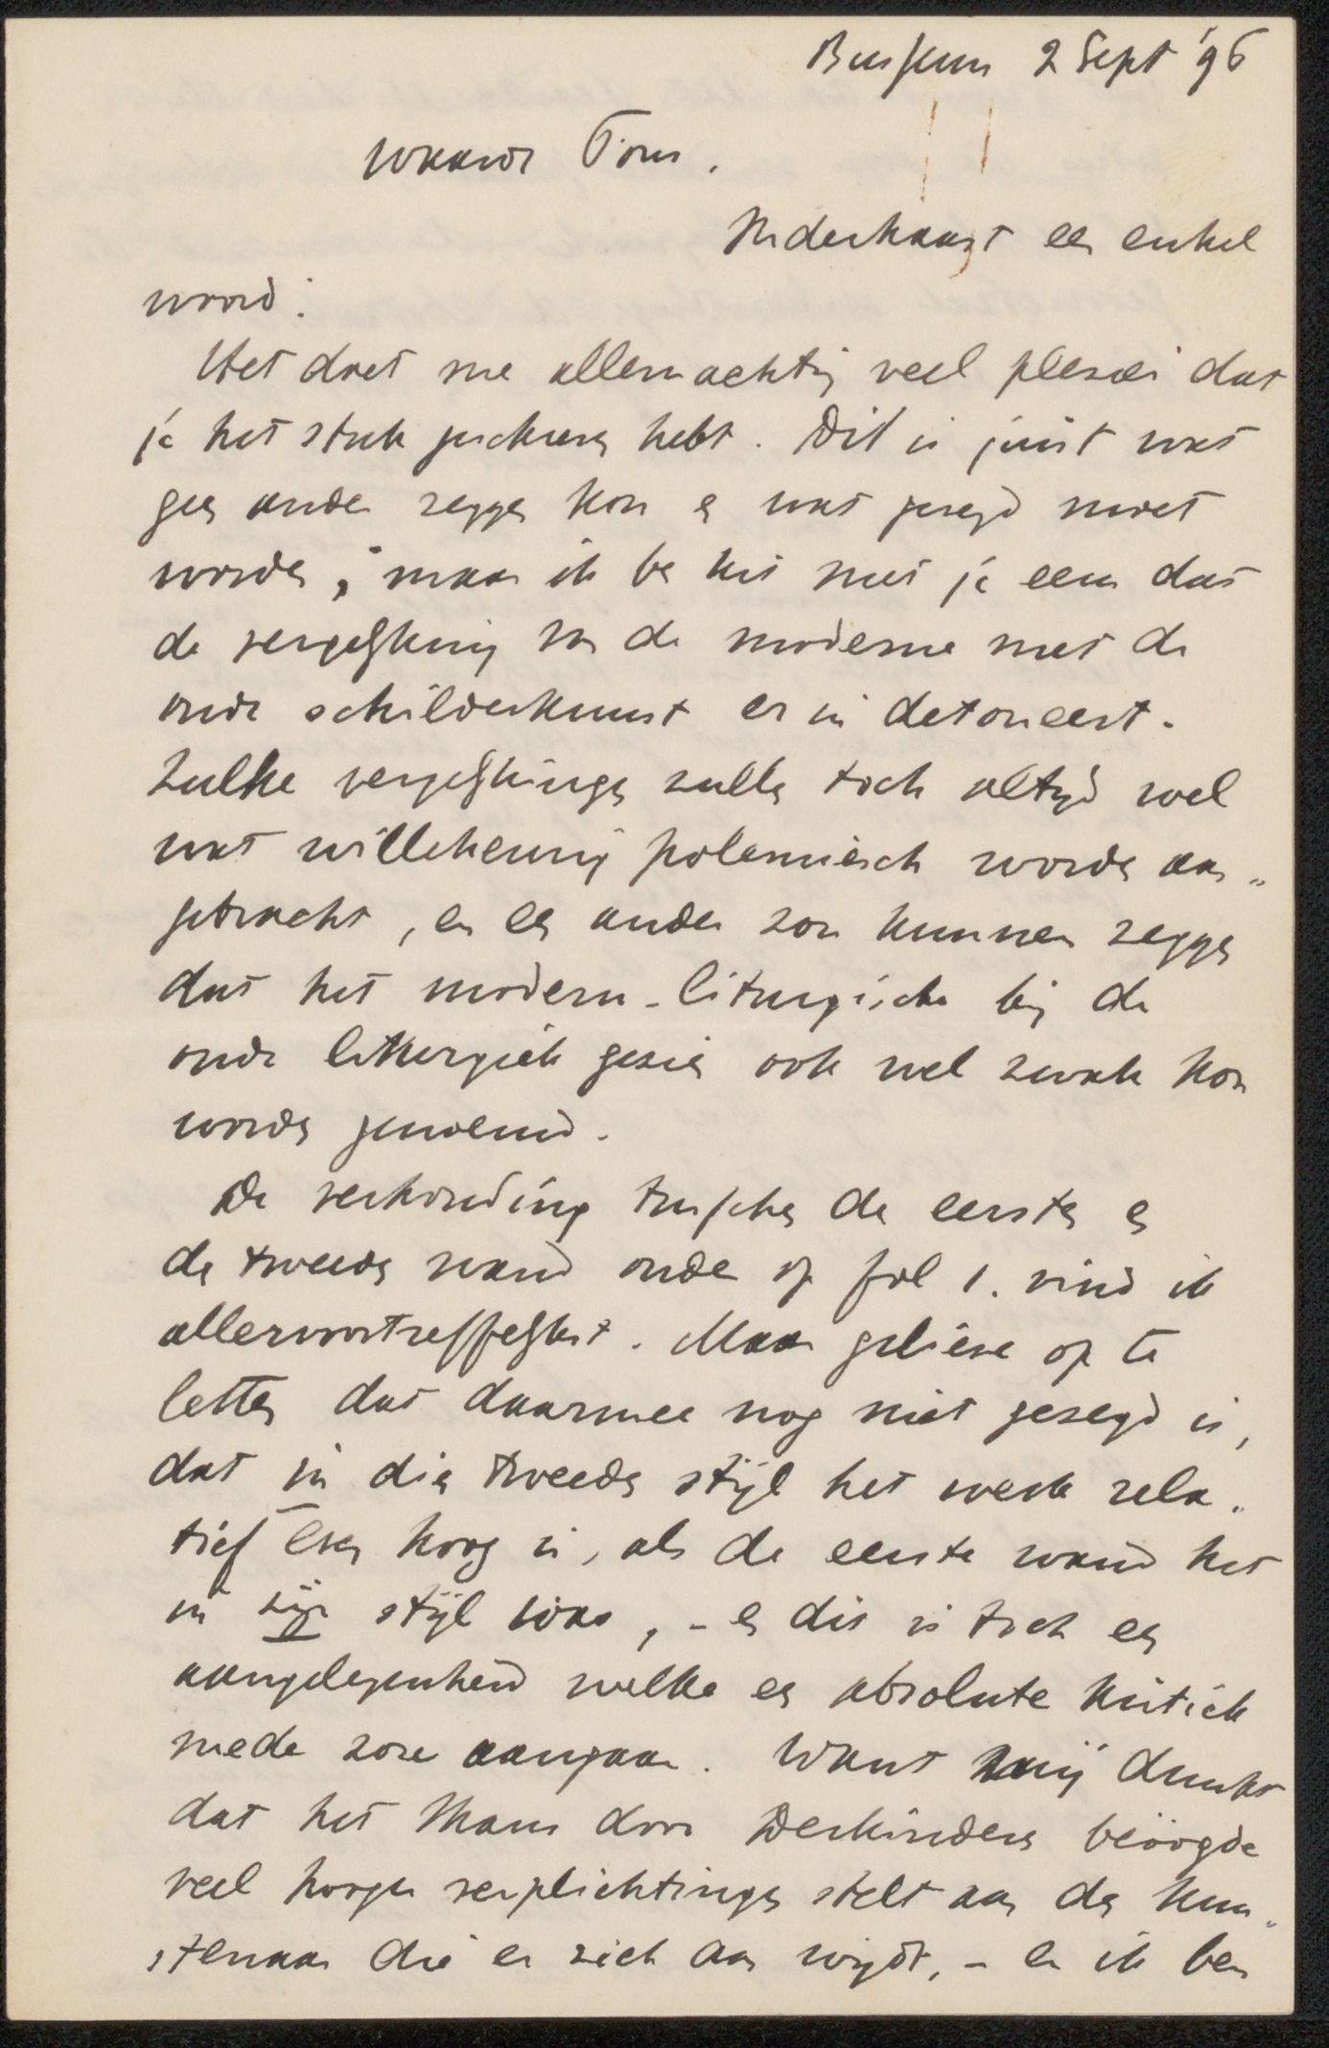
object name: letter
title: Brief aan Alphons Diepenbrock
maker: jan veth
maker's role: designer, draughtsman, painter, print maker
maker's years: 1864-1925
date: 1896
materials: ink, paper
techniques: pen, writing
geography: bussum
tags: den bosch, amsterdam, painter, draughtsman, antoon derkinderen, alphons diepenbrock, applied arts, arts and crafts; industrial design, printed matter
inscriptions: collector's mark: ‘RPK’, watermark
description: Brief RP-D-1984-40-J.P.VETH-111 betreft kladversie.